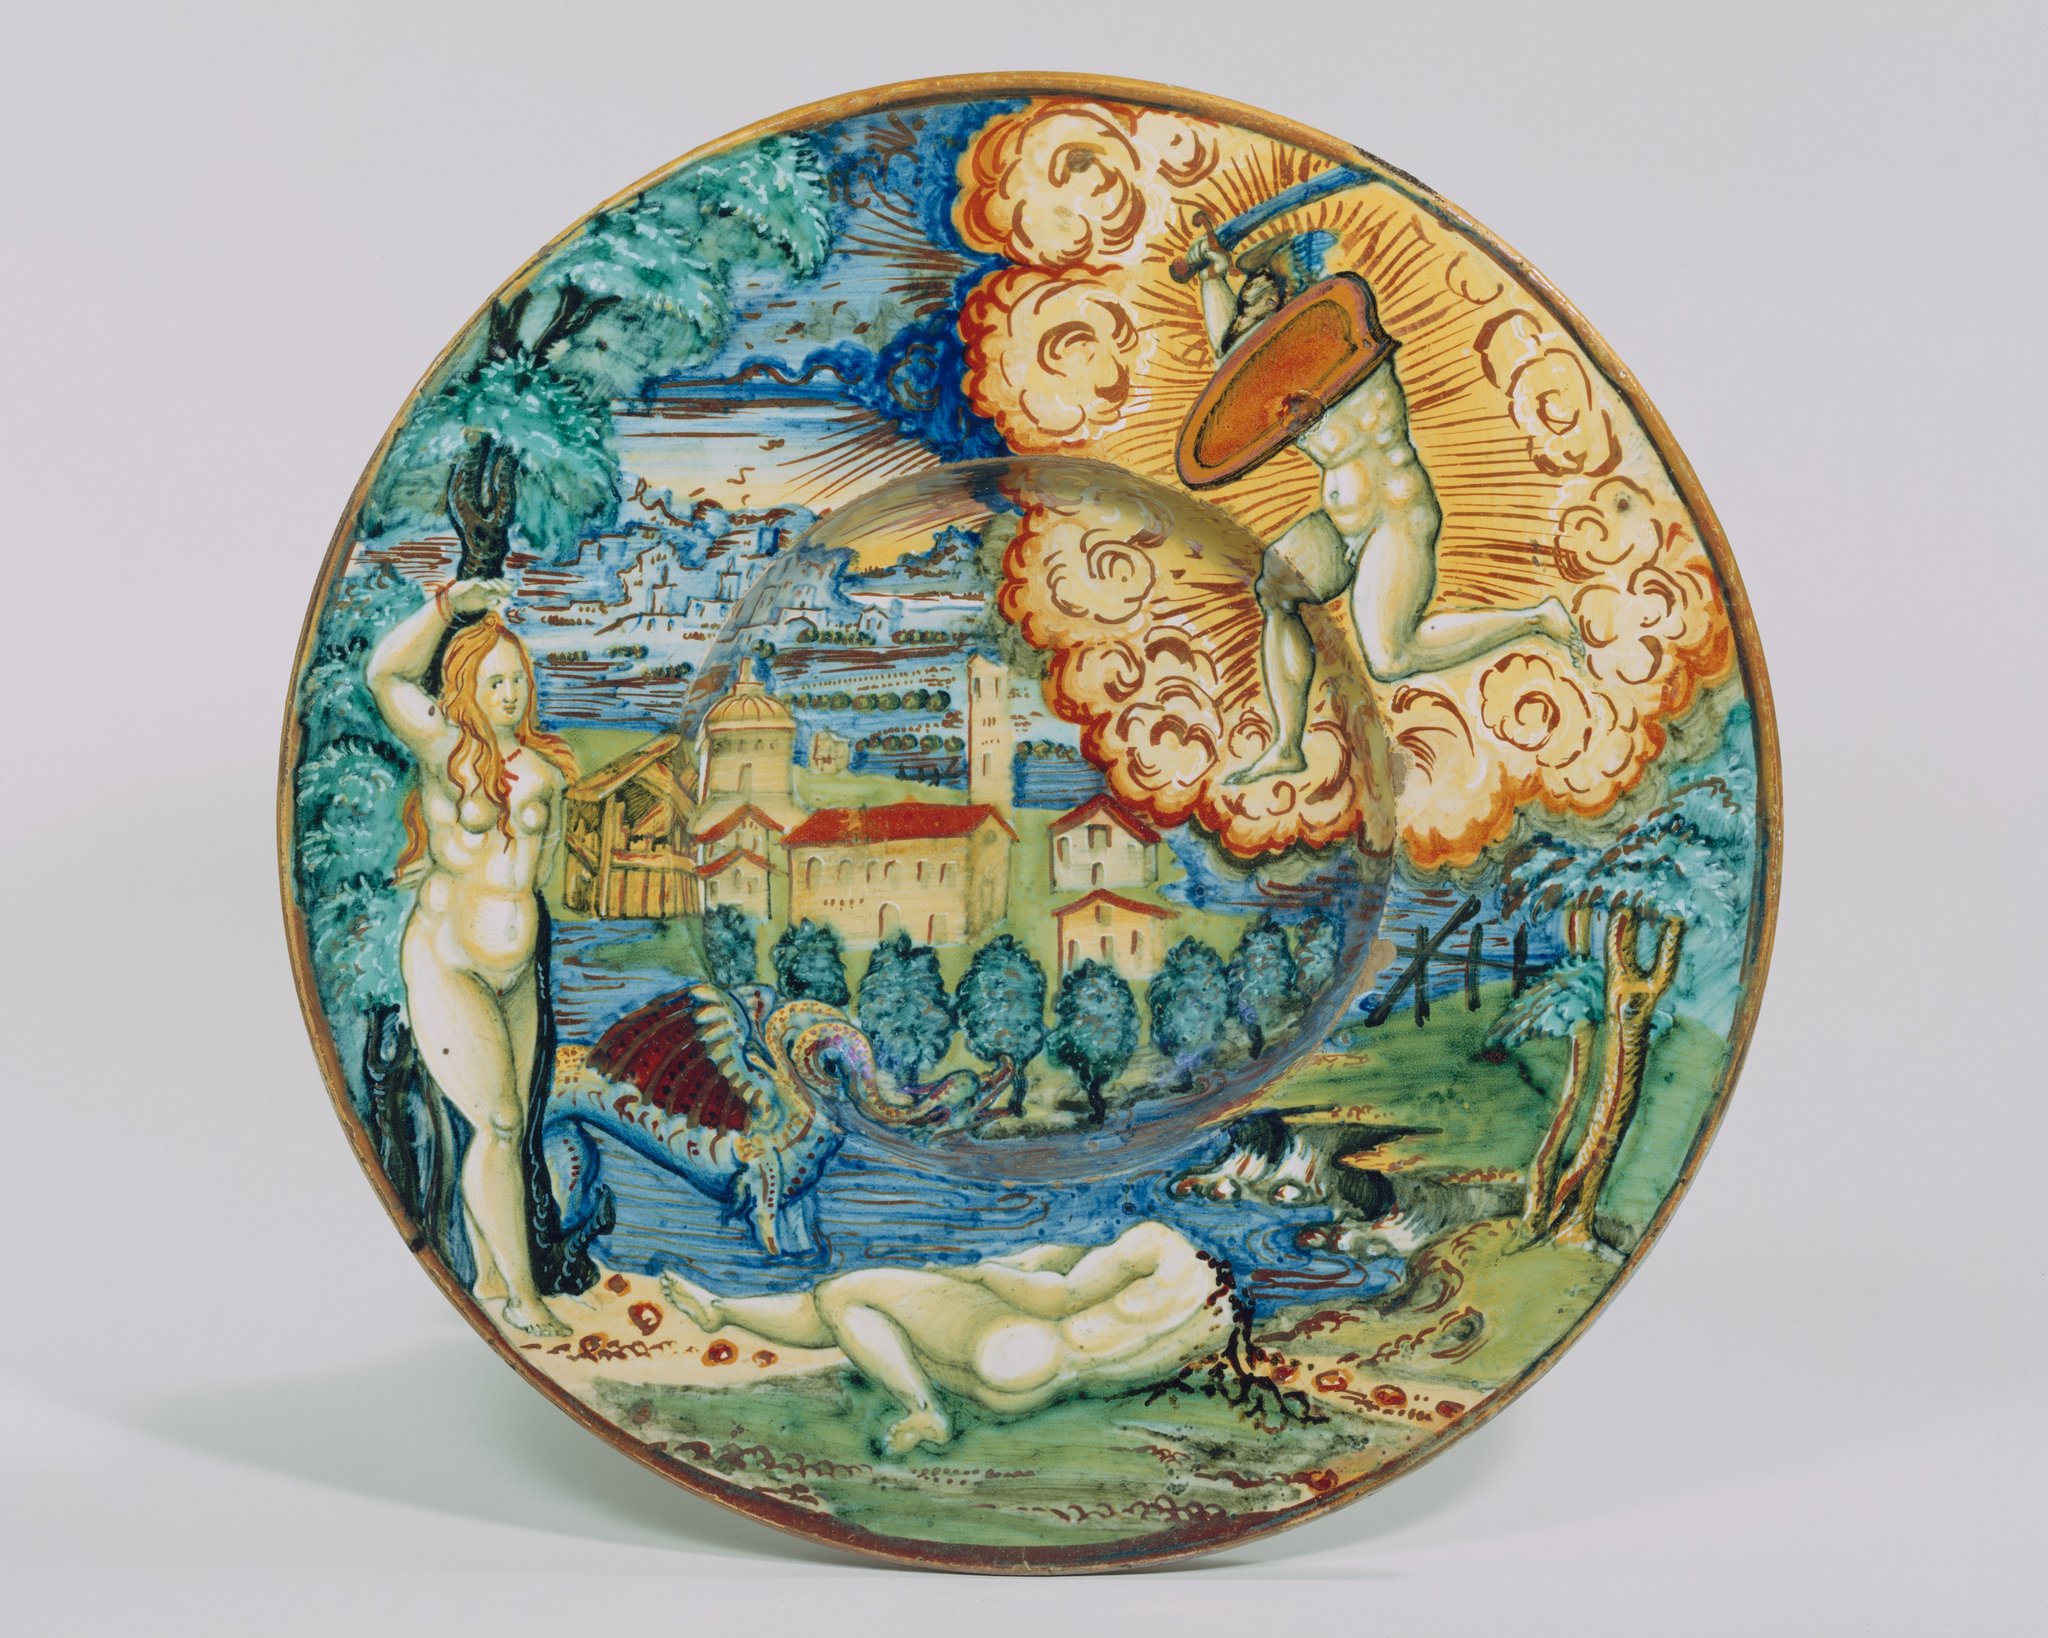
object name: dish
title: Dish (tondino)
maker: maestro giorgio andreoli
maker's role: artist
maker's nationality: italian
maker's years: 1500-1550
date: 1533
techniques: maiolica, glazing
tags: male nudes,female nudes,andromeda,medusa,perseus